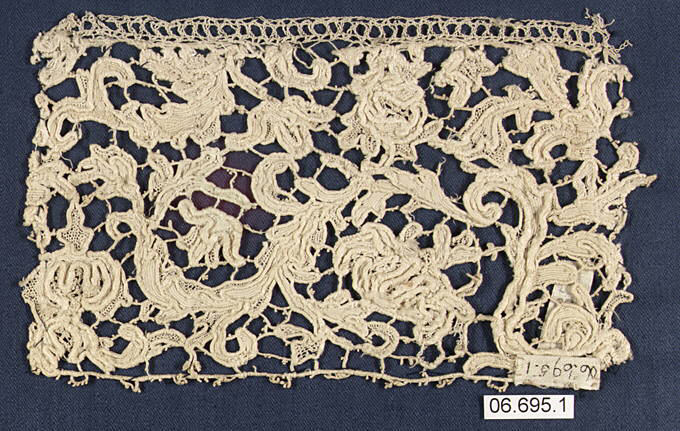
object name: fragment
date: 1701-1733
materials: lace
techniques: gros point, lace